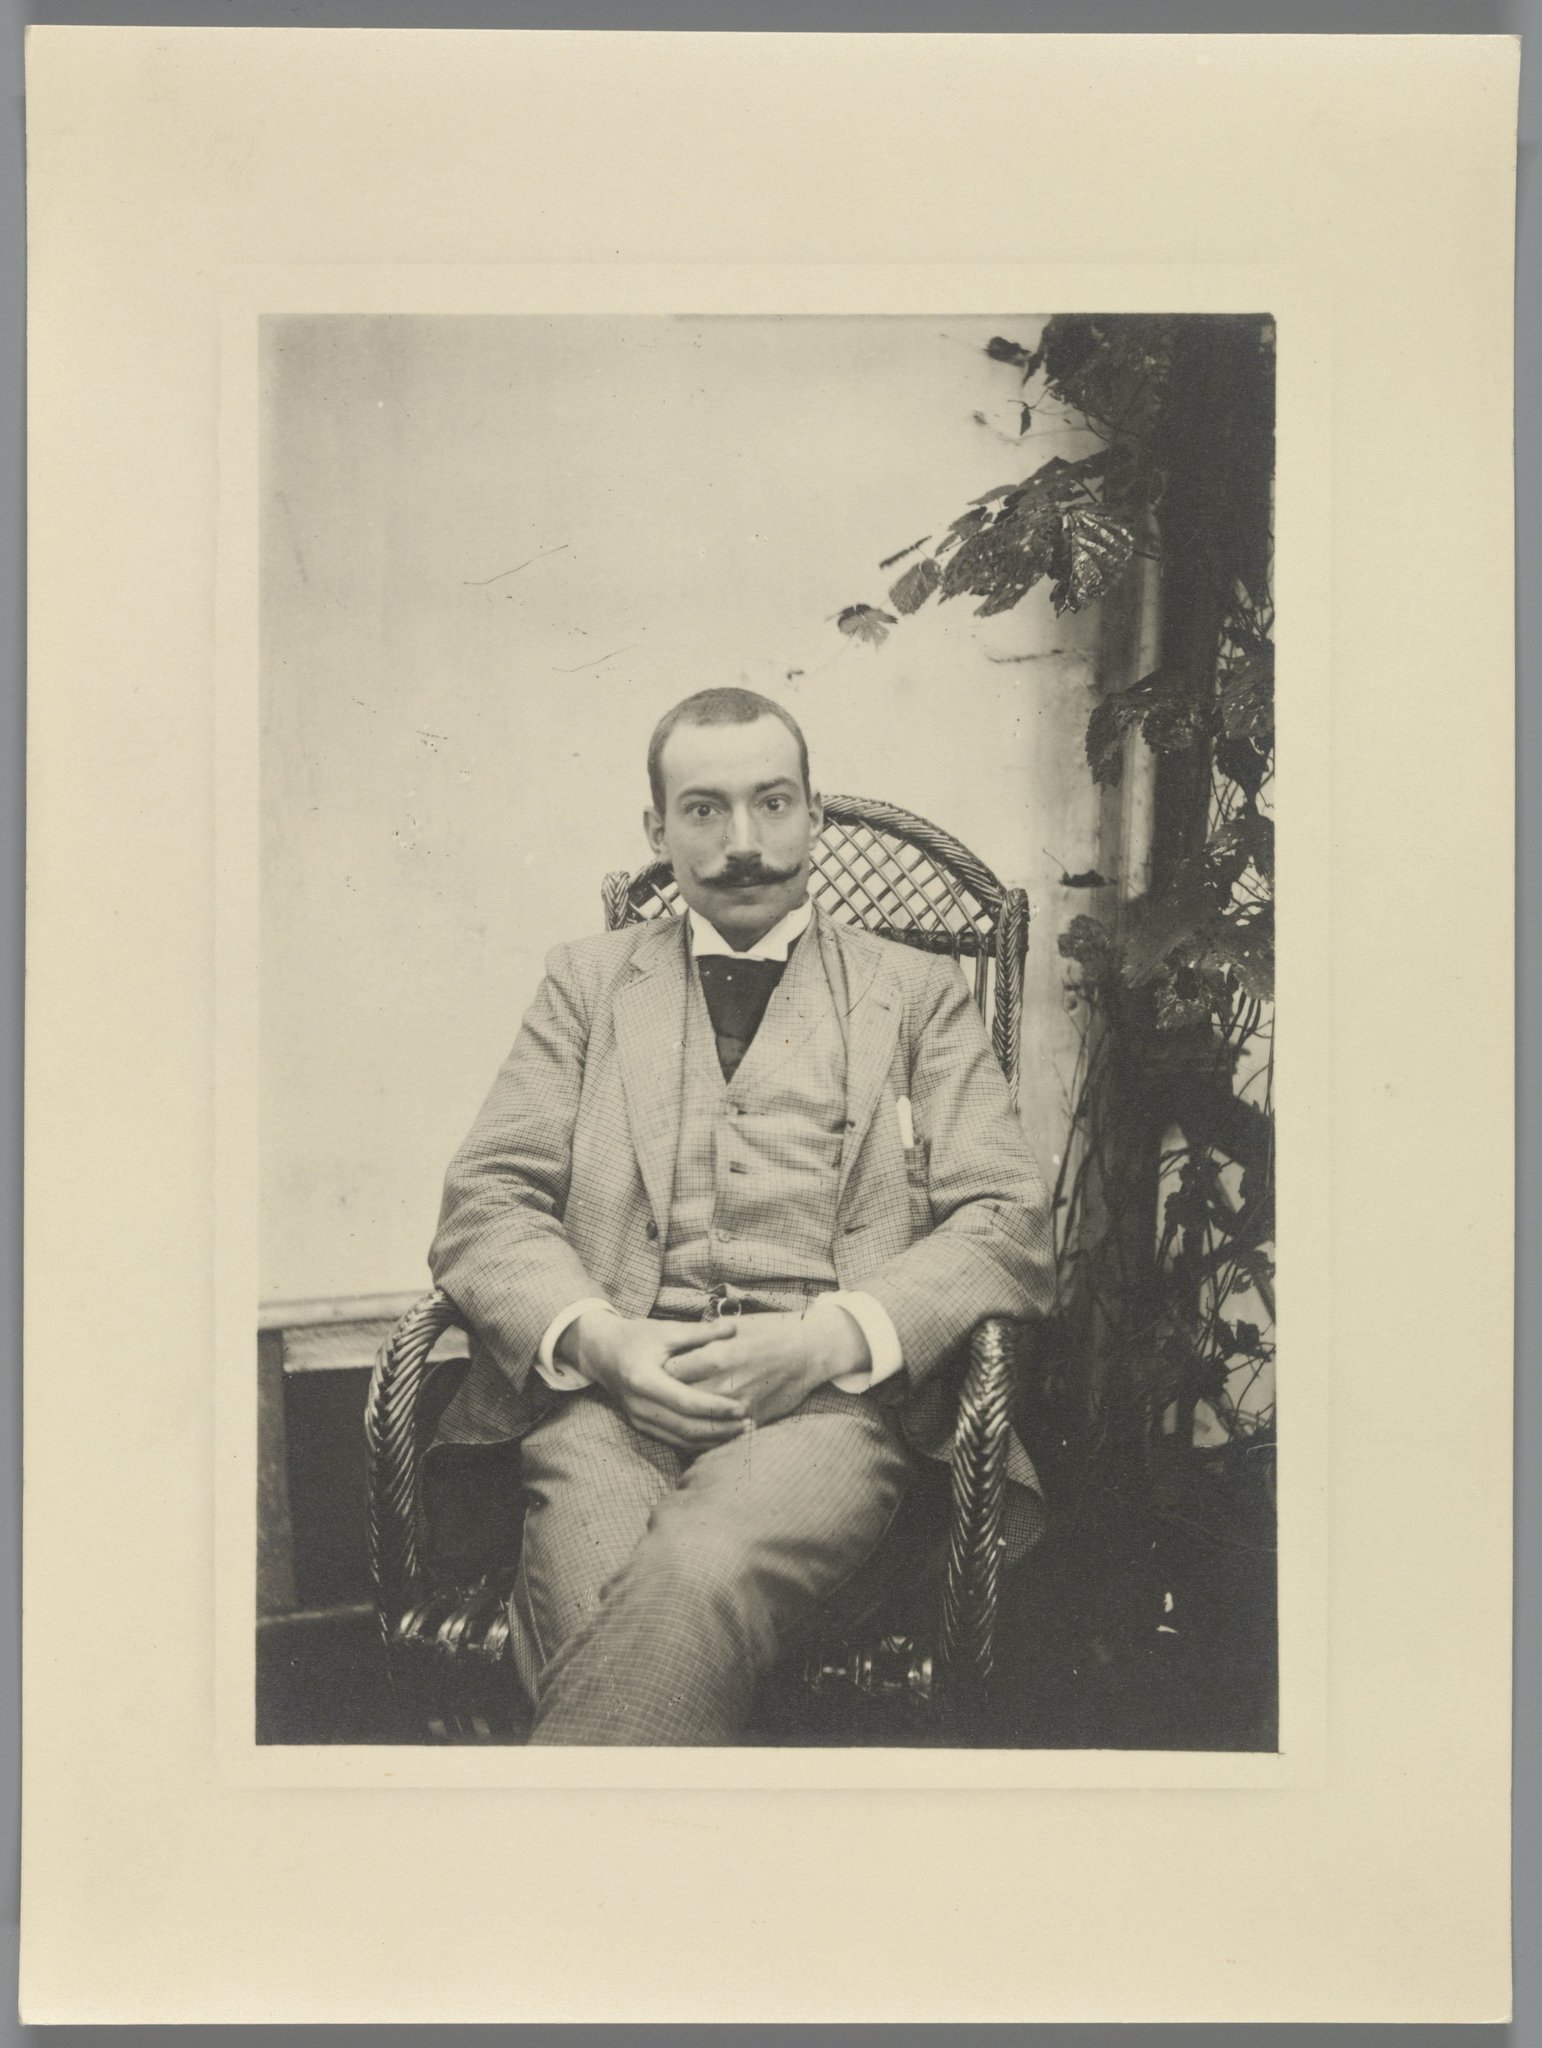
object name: photograph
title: Reproductie naar een foto van Willem Witsen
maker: Anonymous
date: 1860-1915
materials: paper, photographic support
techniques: gelatin silver print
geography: netherlands